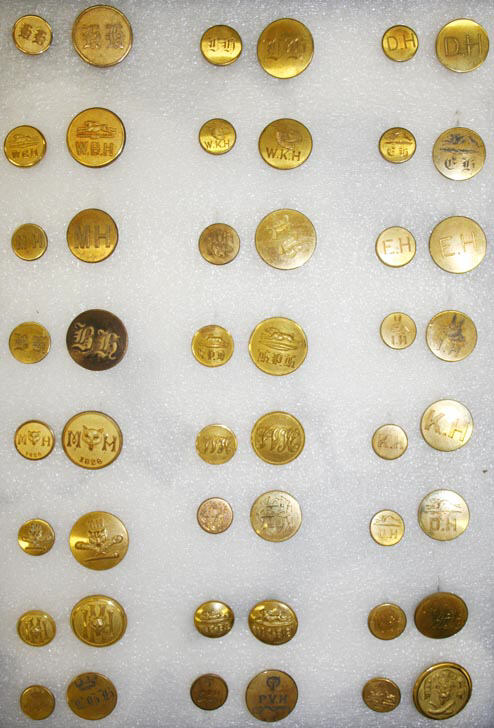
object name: button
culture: british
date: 1850-1880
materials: metal